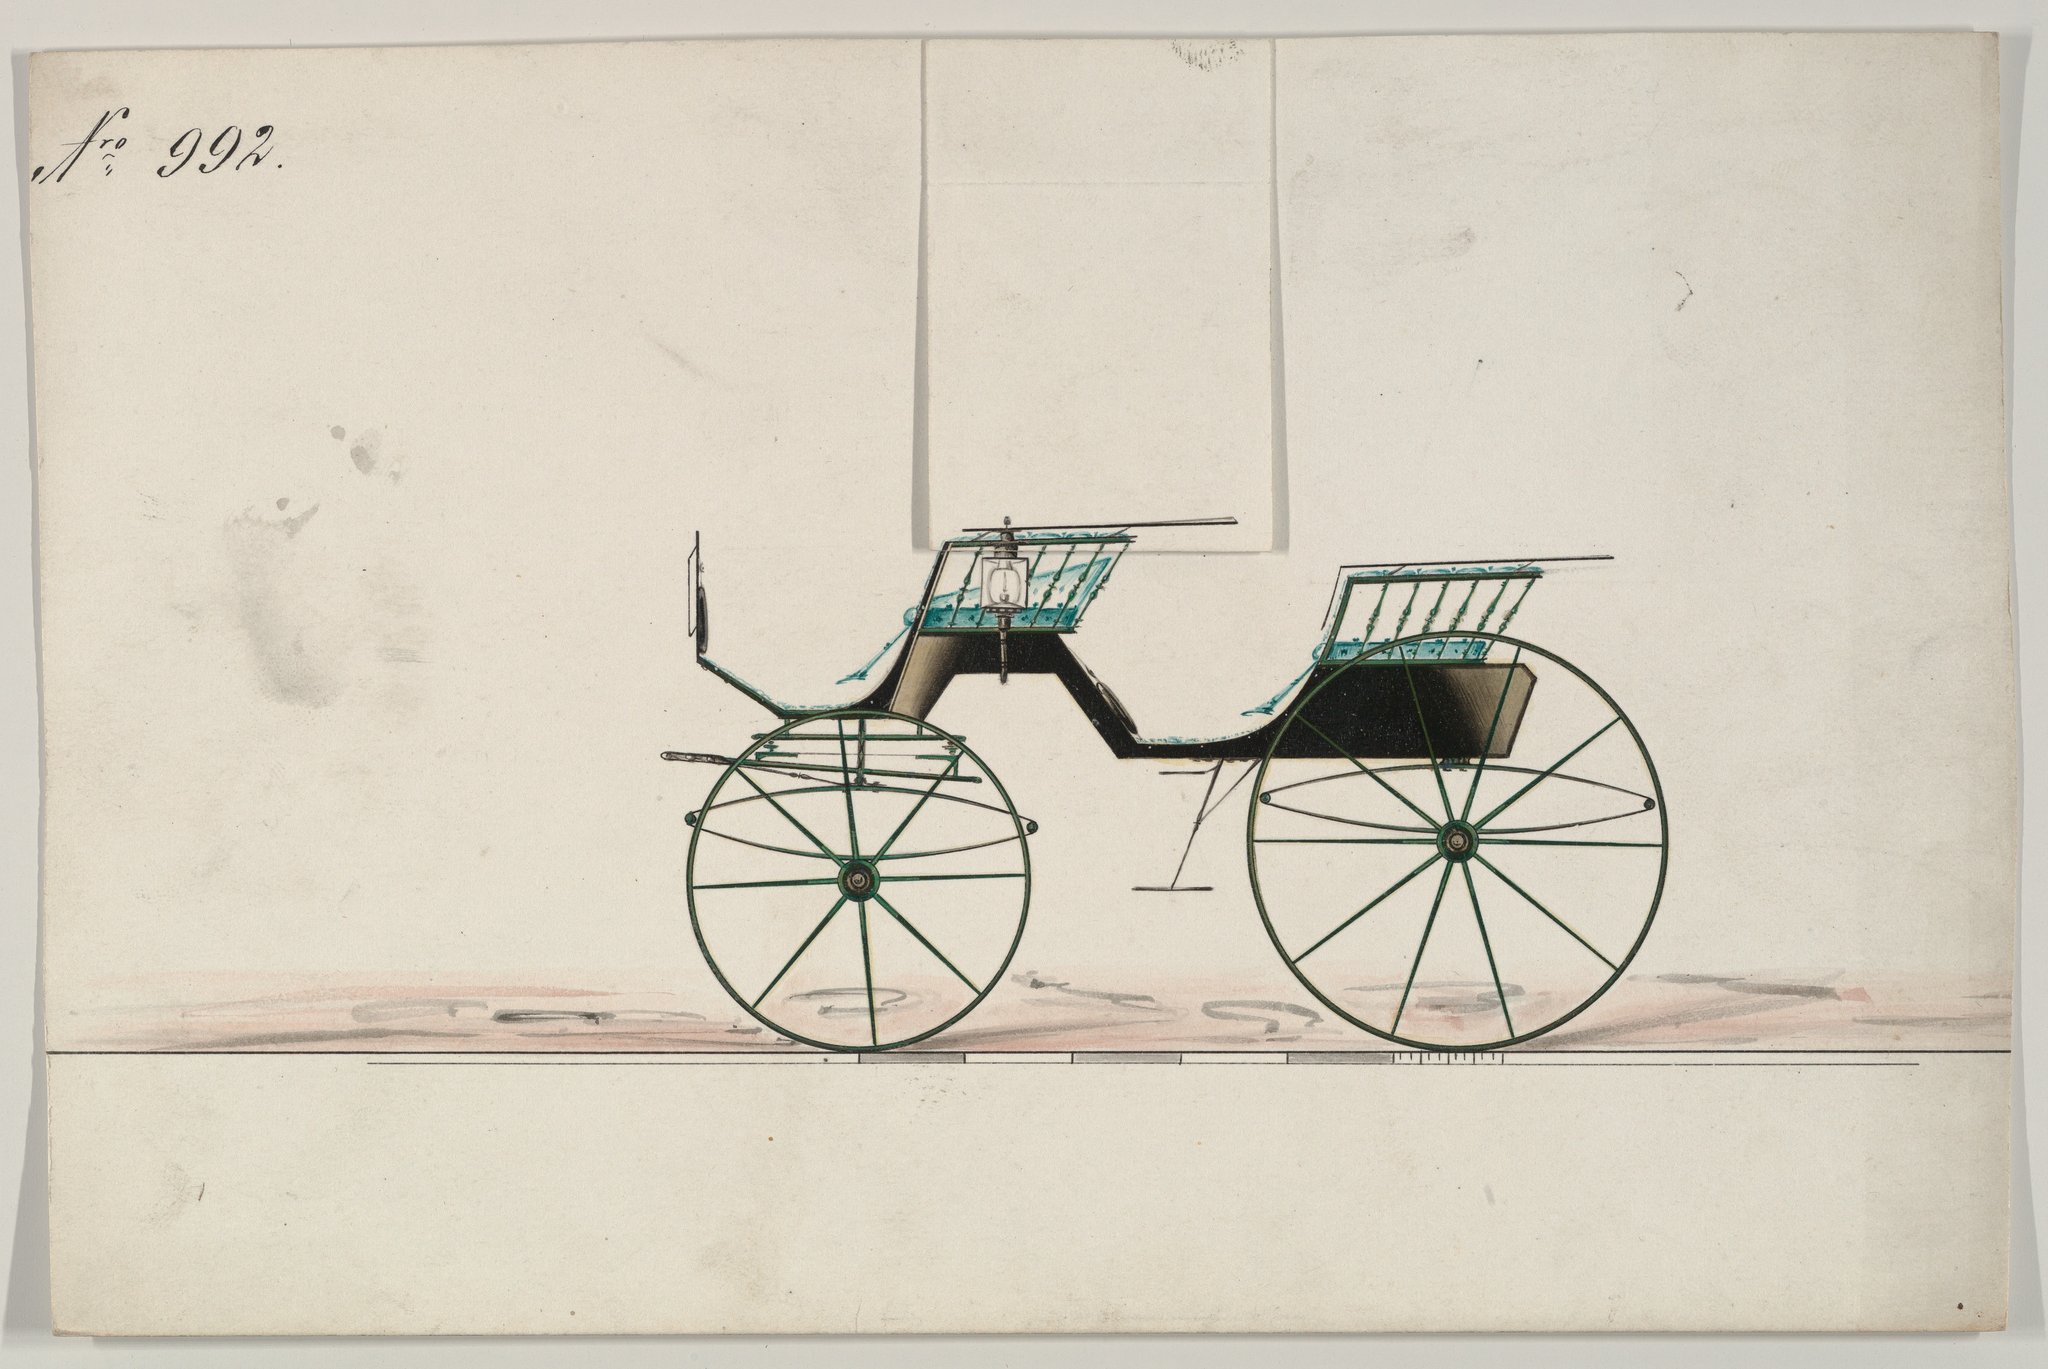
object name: drawing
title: Design for Phaeton, no. 992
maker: brewster & co.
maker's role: manufacturer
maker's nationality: american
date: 1850-1874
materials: gouache, gum arabic, ink, watercolor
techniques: pen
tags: carriages